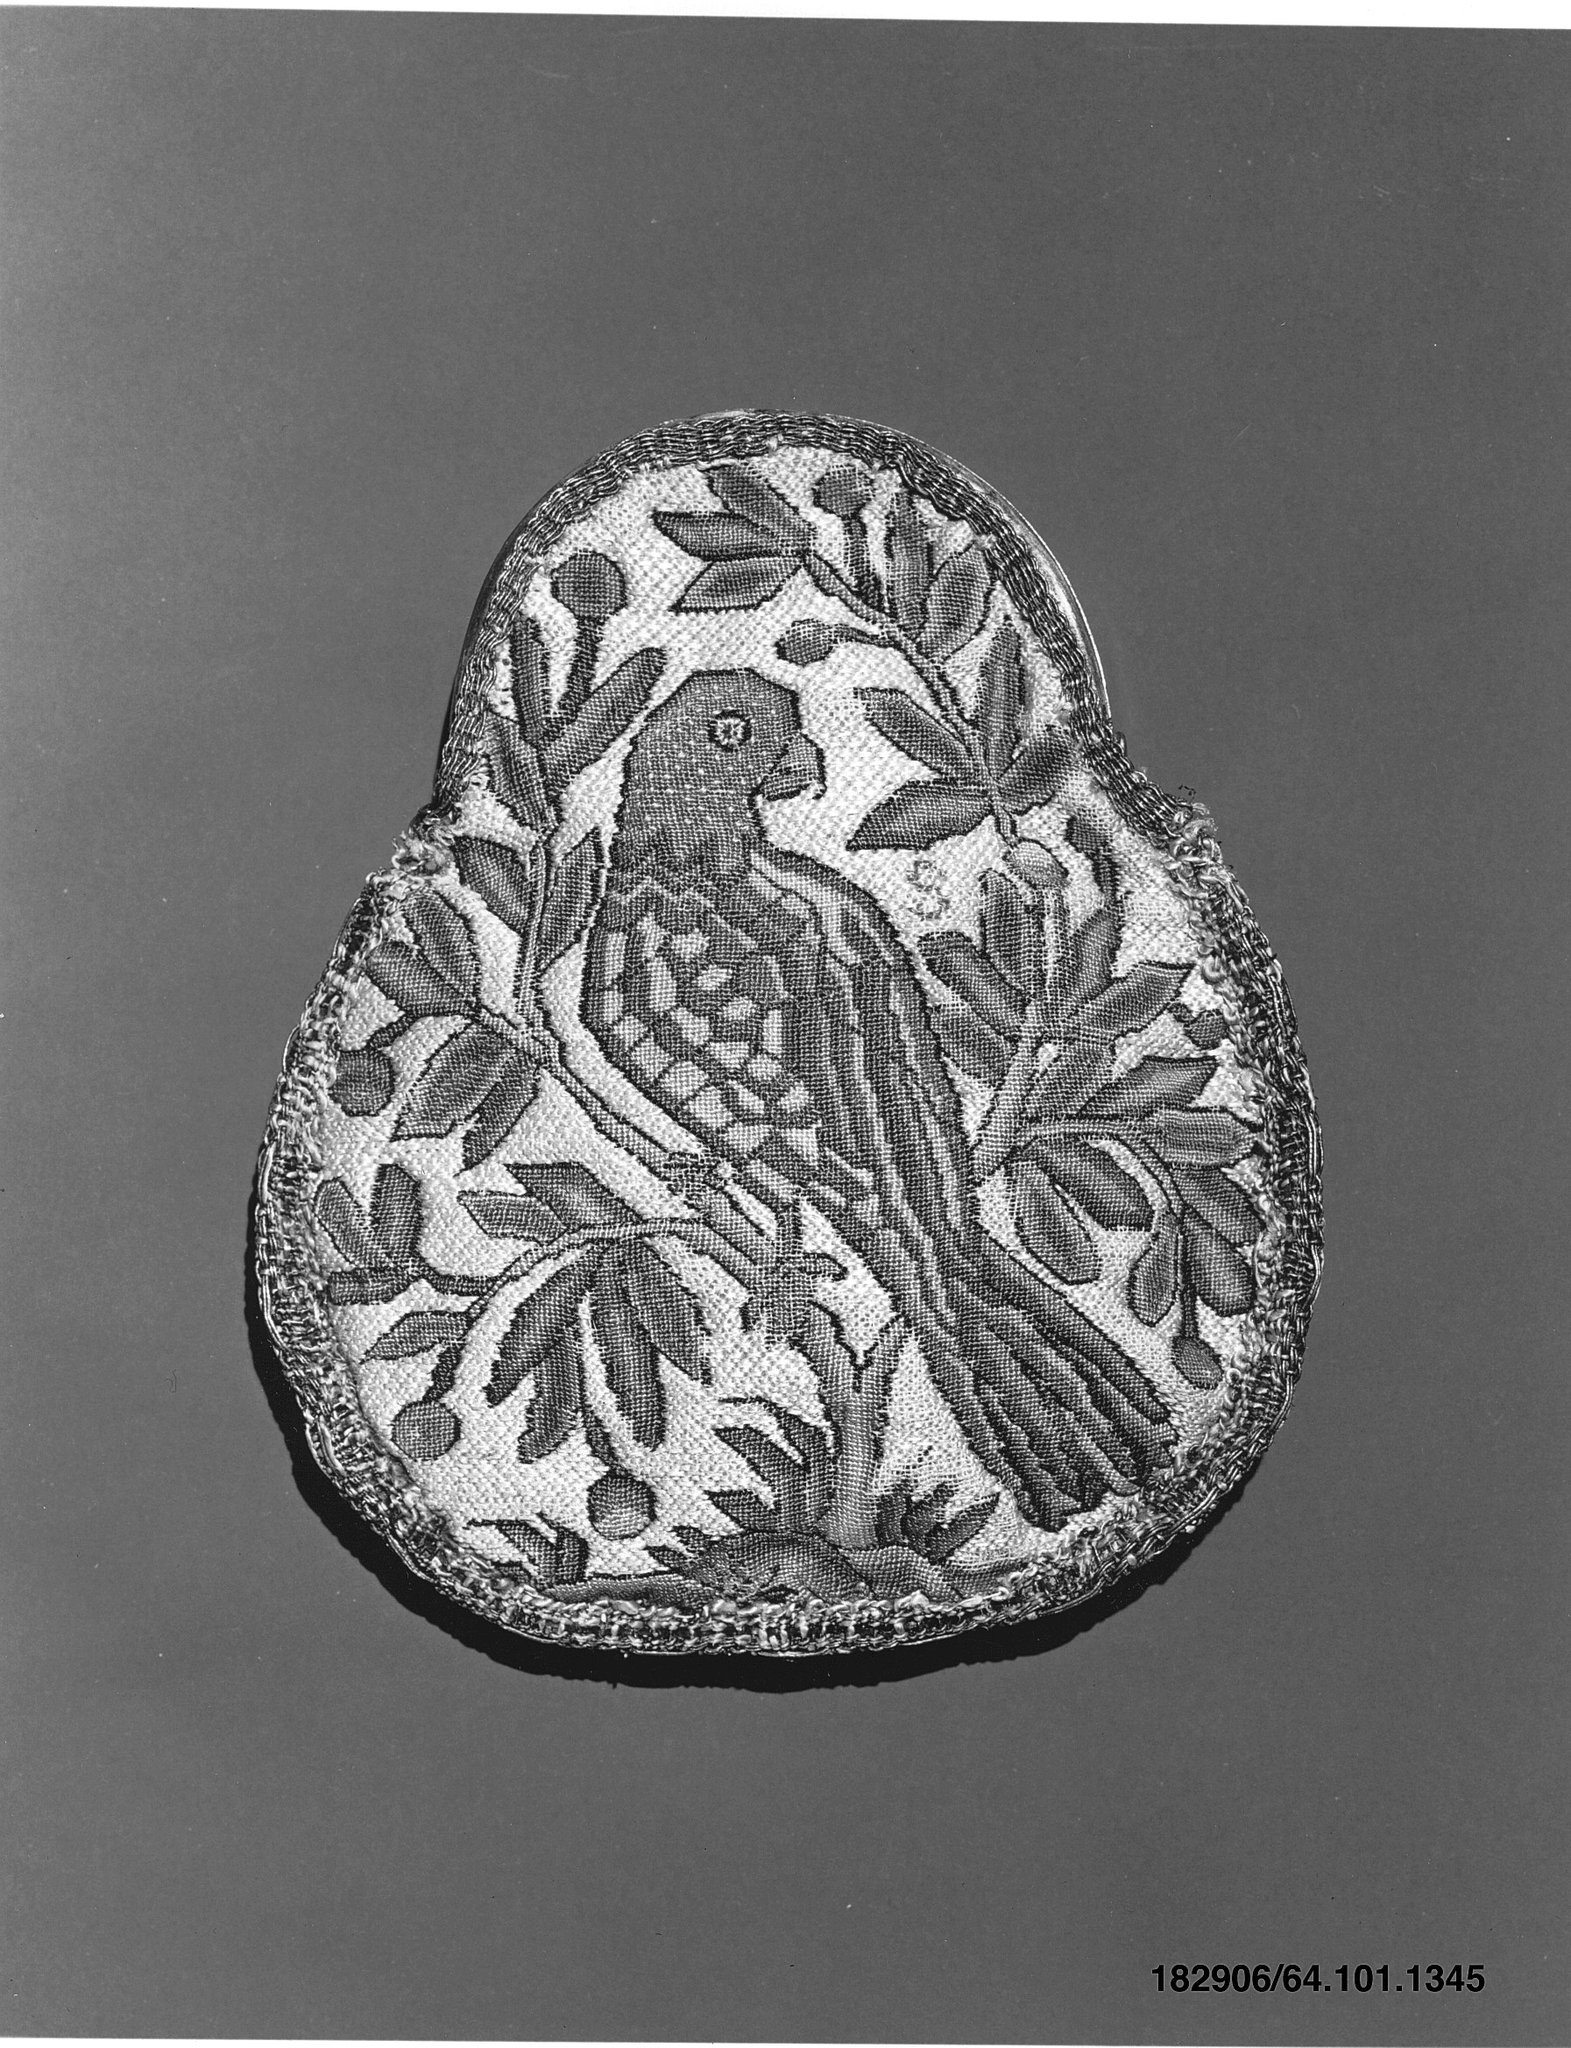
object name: purse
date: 1701-1725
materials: canvas, silk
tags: birds